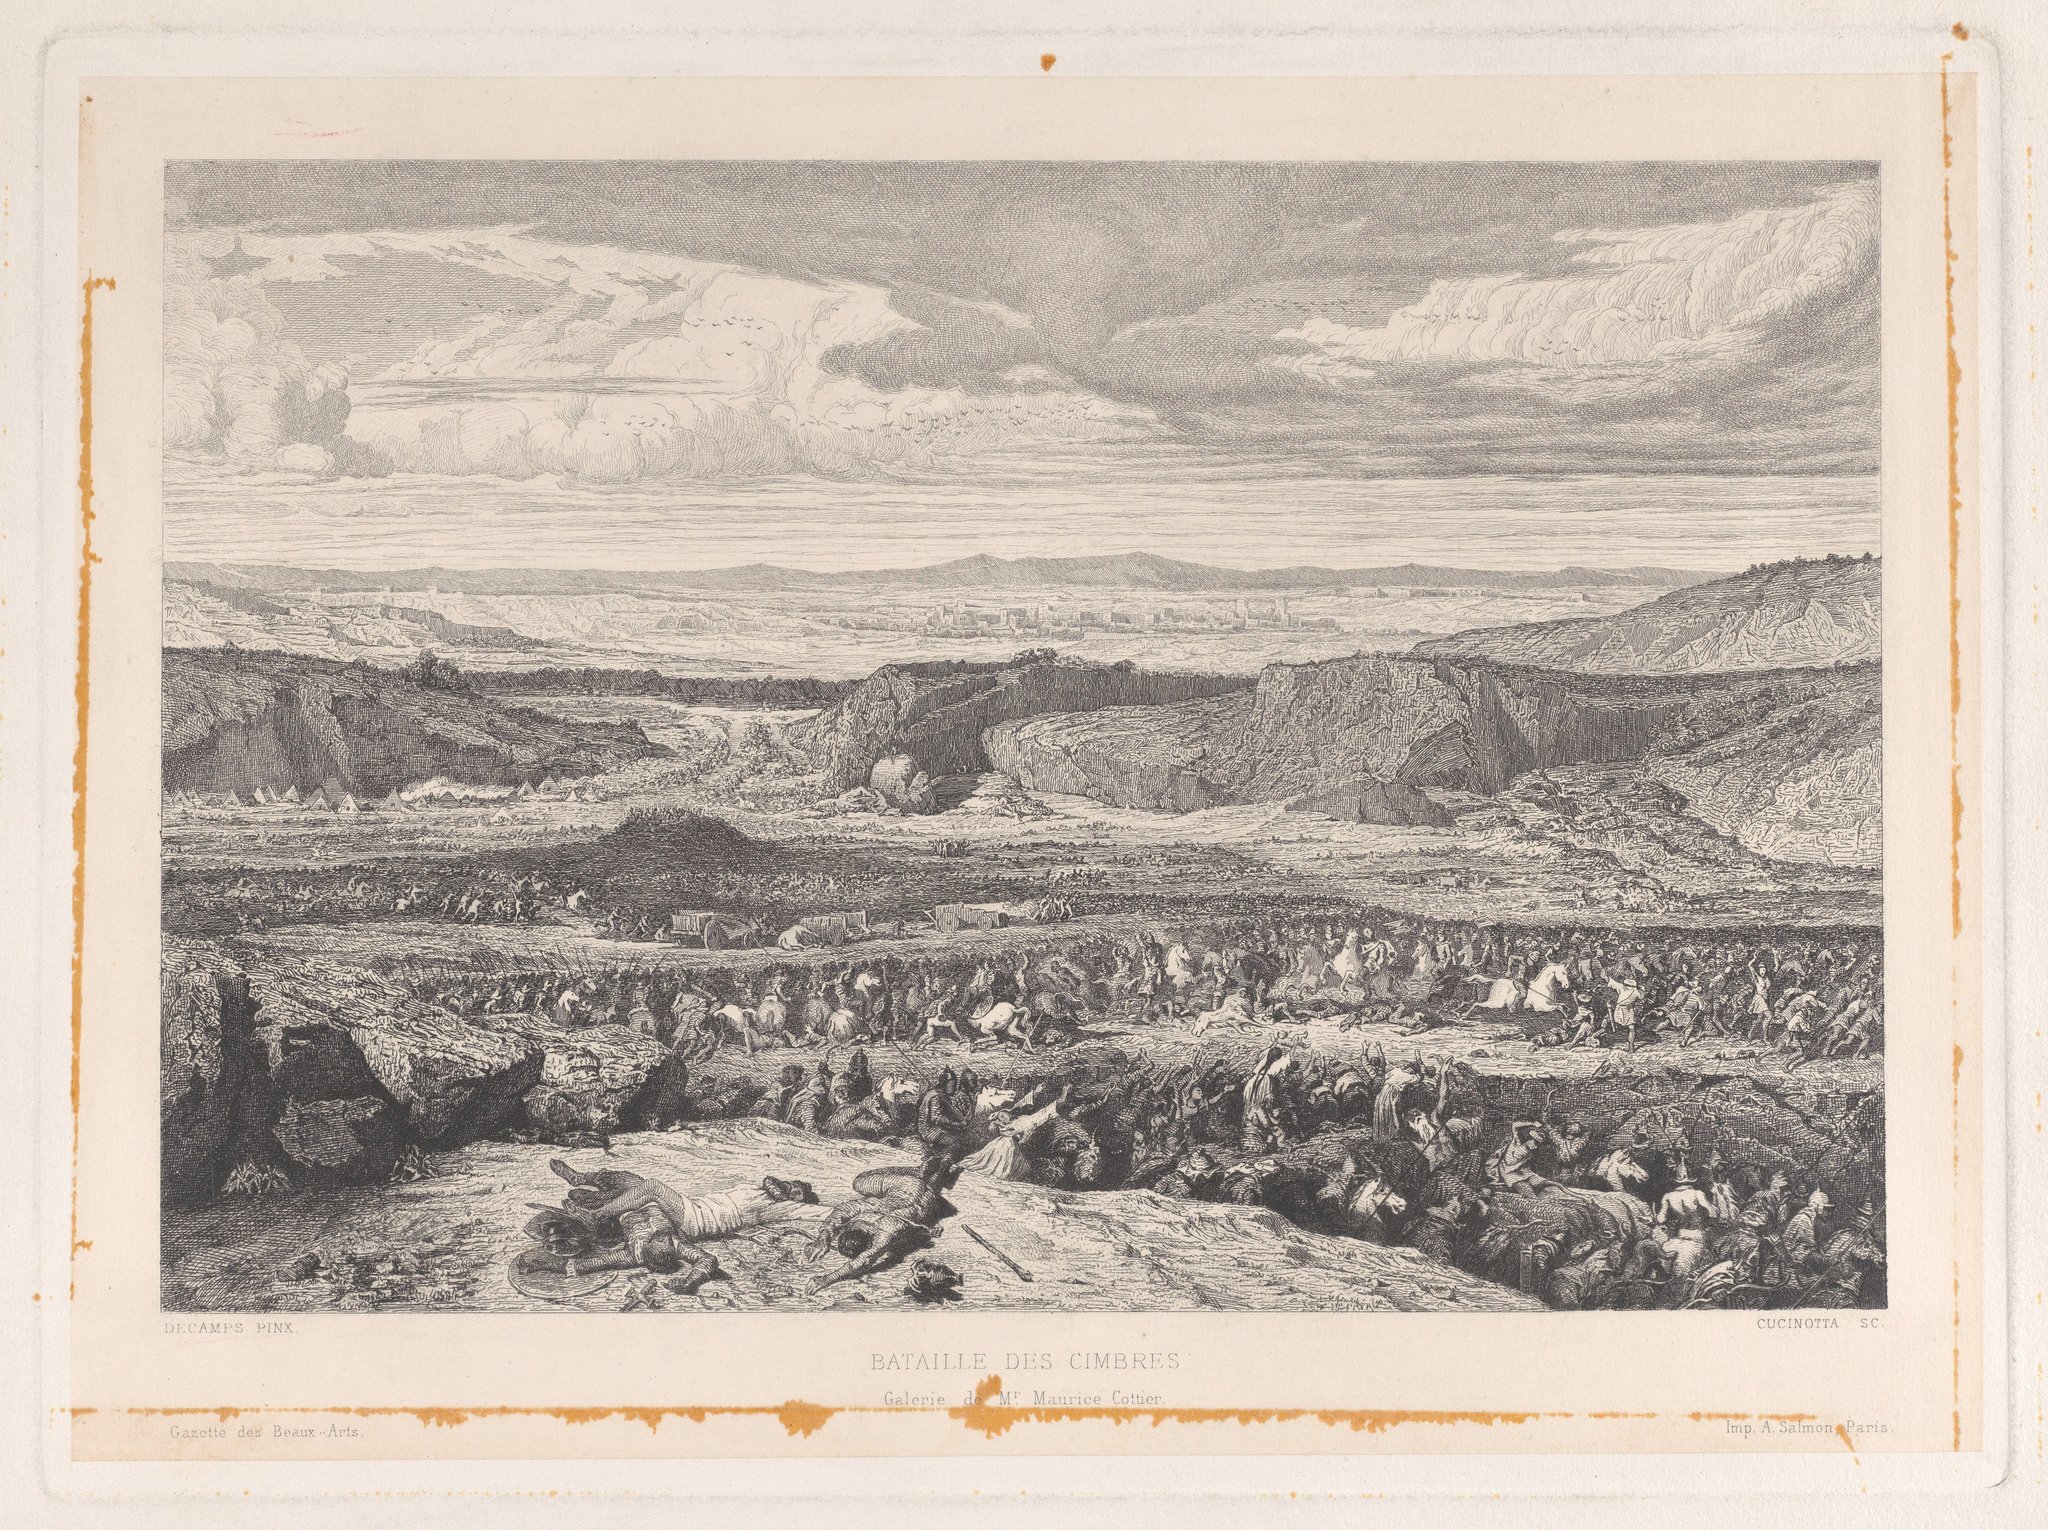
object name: print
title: Bataille des Cimbres, from "Gazette des Beaux-Arts"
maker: saro cucinotta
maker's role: artist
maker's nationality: italian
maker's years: 1830-1871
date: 1850-1871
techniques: etching